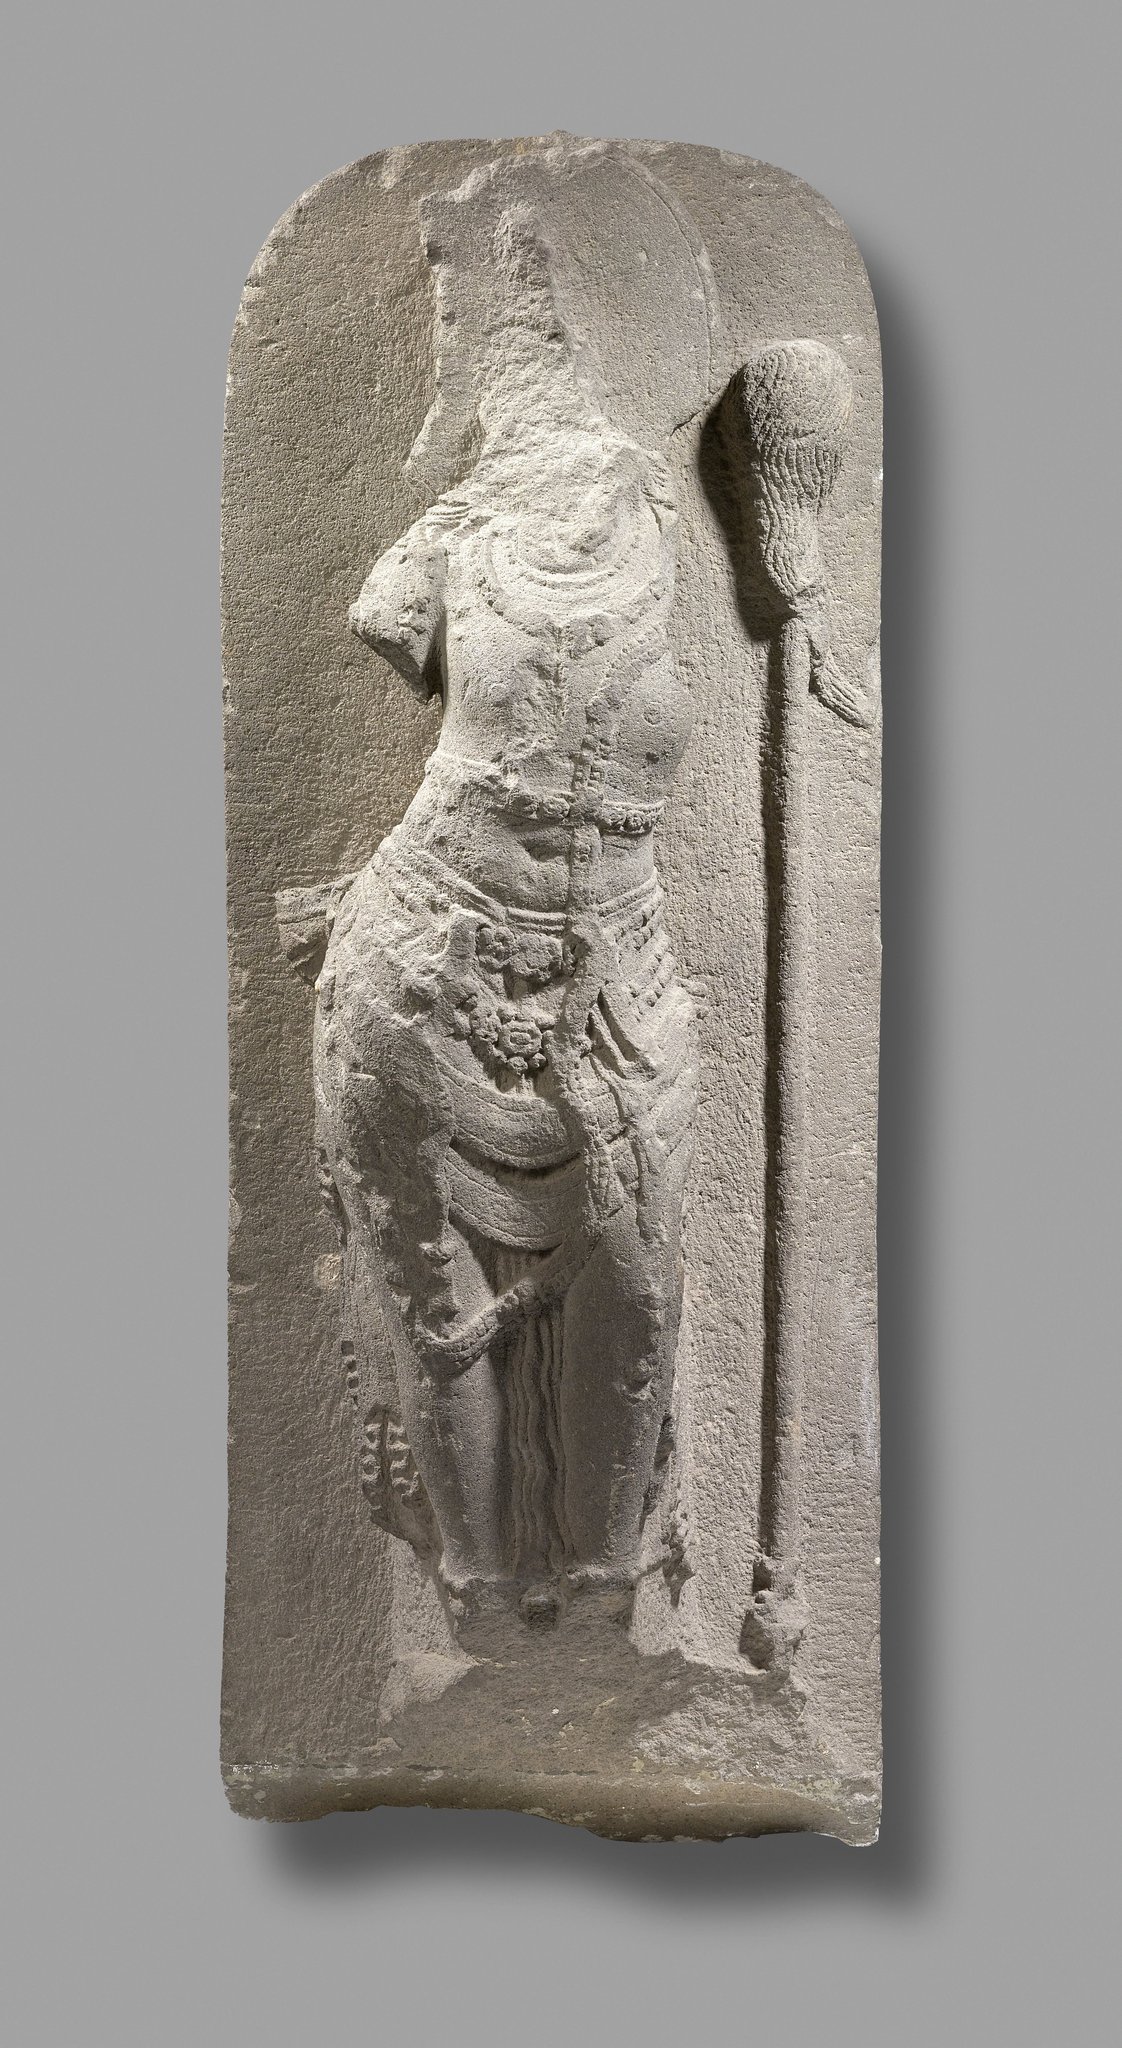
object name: sculpture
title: Beeldfragment: hoofd, armen en voeten ontbreken.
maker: Anonymous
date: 800-900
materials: stone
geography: central java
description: Beeldfragment, hoofd, armen en voeten ontbreken